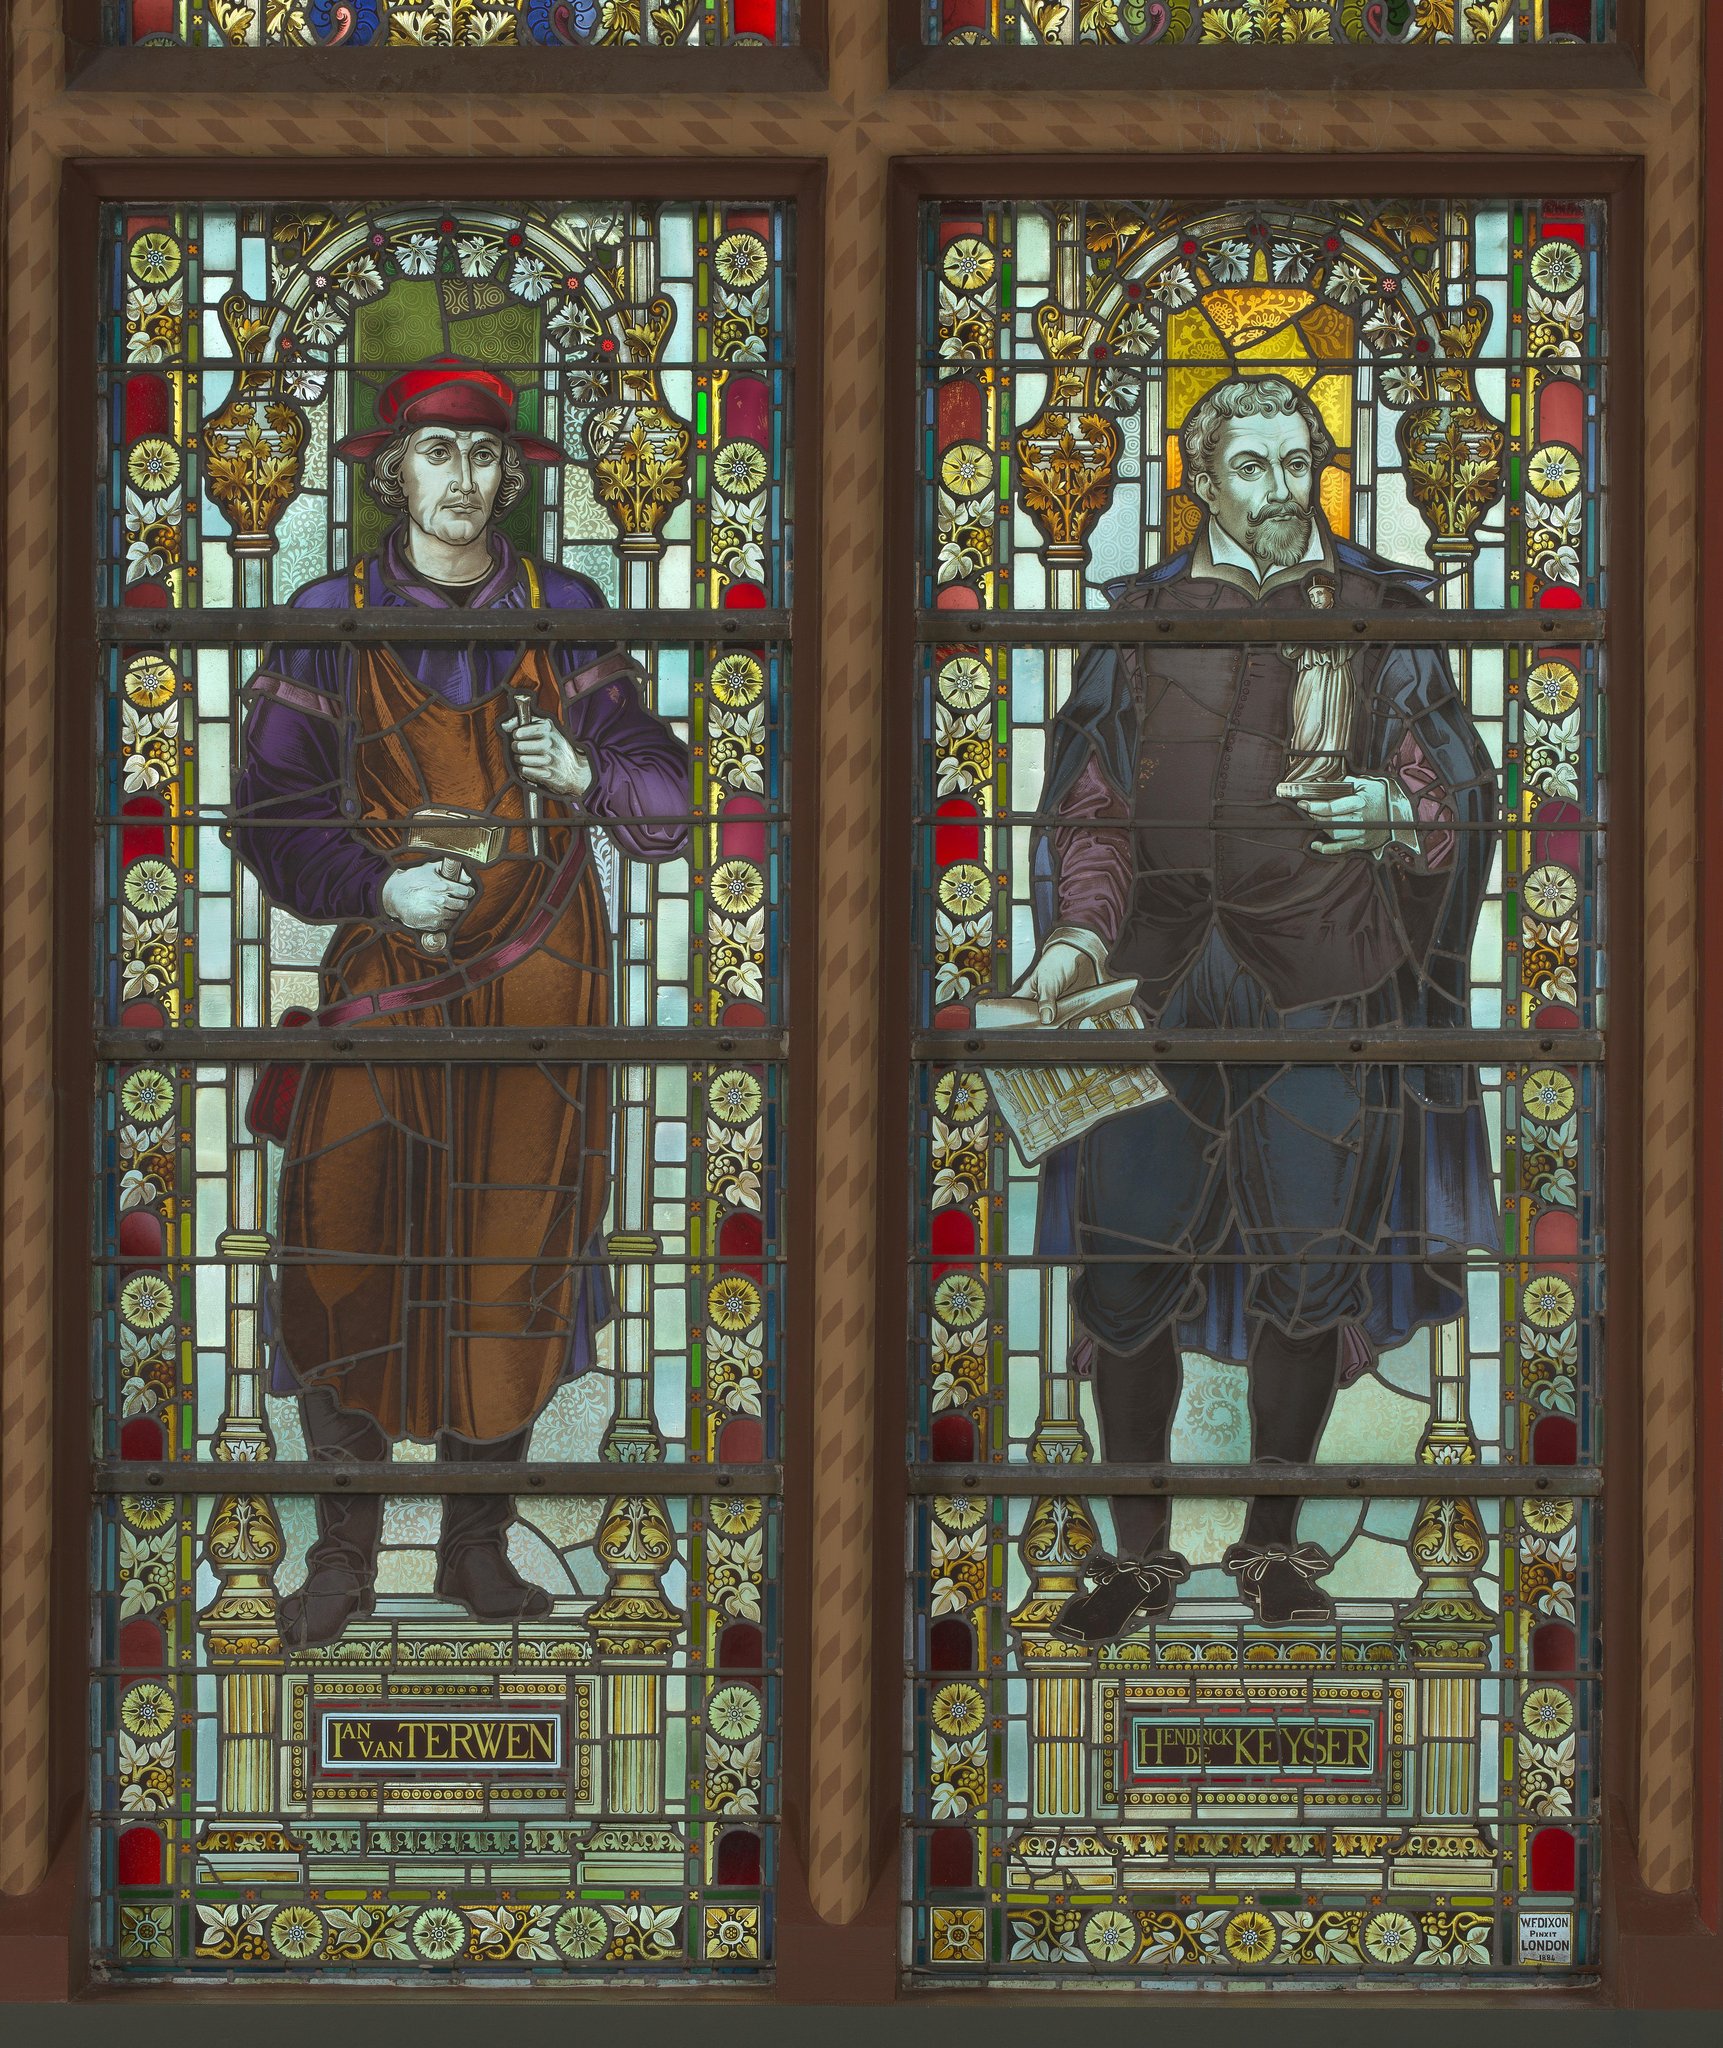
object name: light window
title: Raam met voorstelling van de beeldhouwer Hendrick de Keyser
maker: william francis dixon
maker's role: glasschilder, glazenier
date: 1883-1884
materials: glass, lead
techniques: leading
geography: england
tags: utrecht, amsterdam, print maker, sculptor, hendrick de keyser (i)